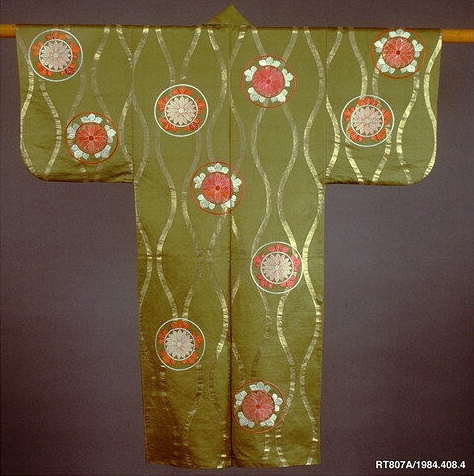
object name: noh robe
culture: japanese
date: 1868-1912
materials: metal thread, silk